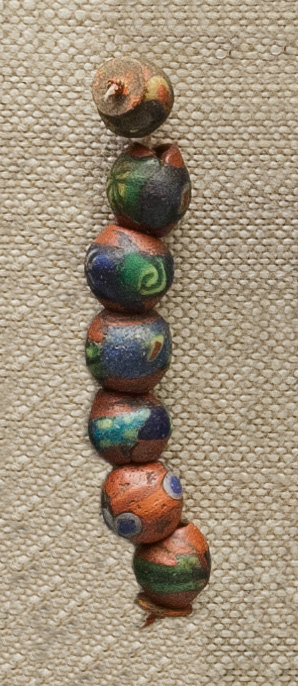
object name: bead, string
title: String of 7 Beads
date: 364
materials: glass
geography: egypt